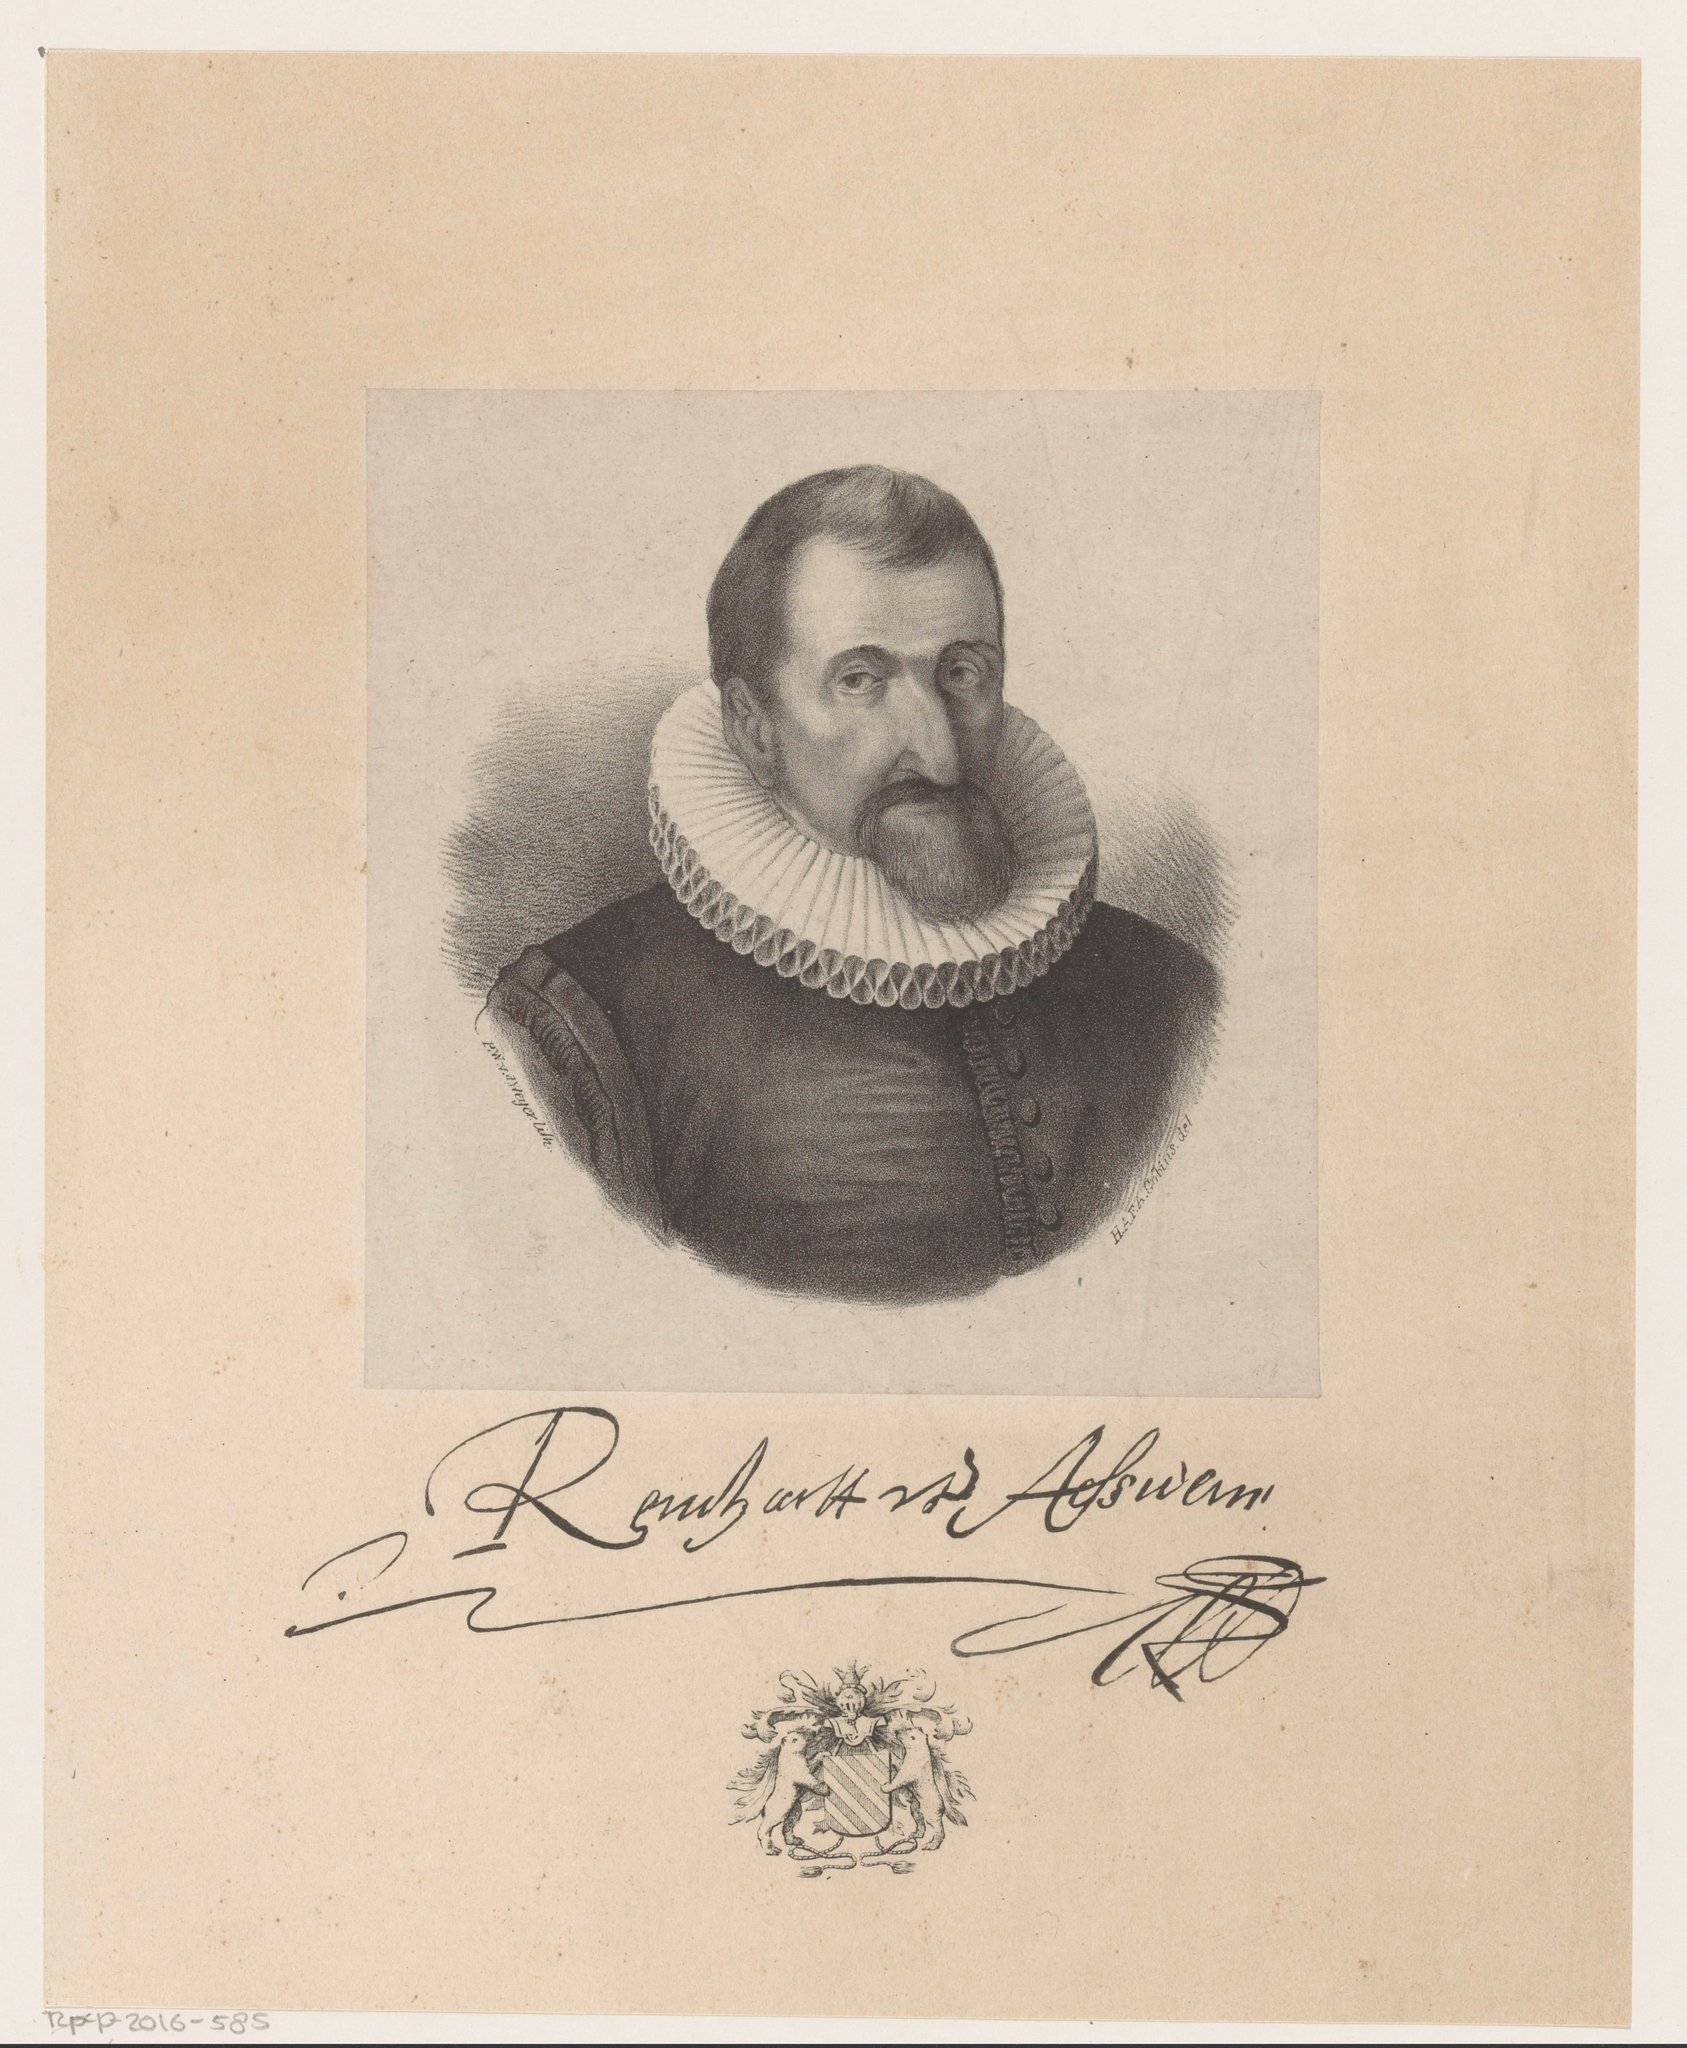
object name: print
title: Portret van Reinhardt van Aesswijn op 80-jarige leeftijd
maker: pieter wilhelmus van de weijer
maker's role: print maker, printer, publisher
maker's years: 1816-1880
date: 1852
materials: paper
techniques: lithograph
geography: utrecht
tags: reynier van asewyn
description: Portret van Reinhardt van Aesswijn. Midden onder zijn wapen. In de ondermarge zijn handtekening.